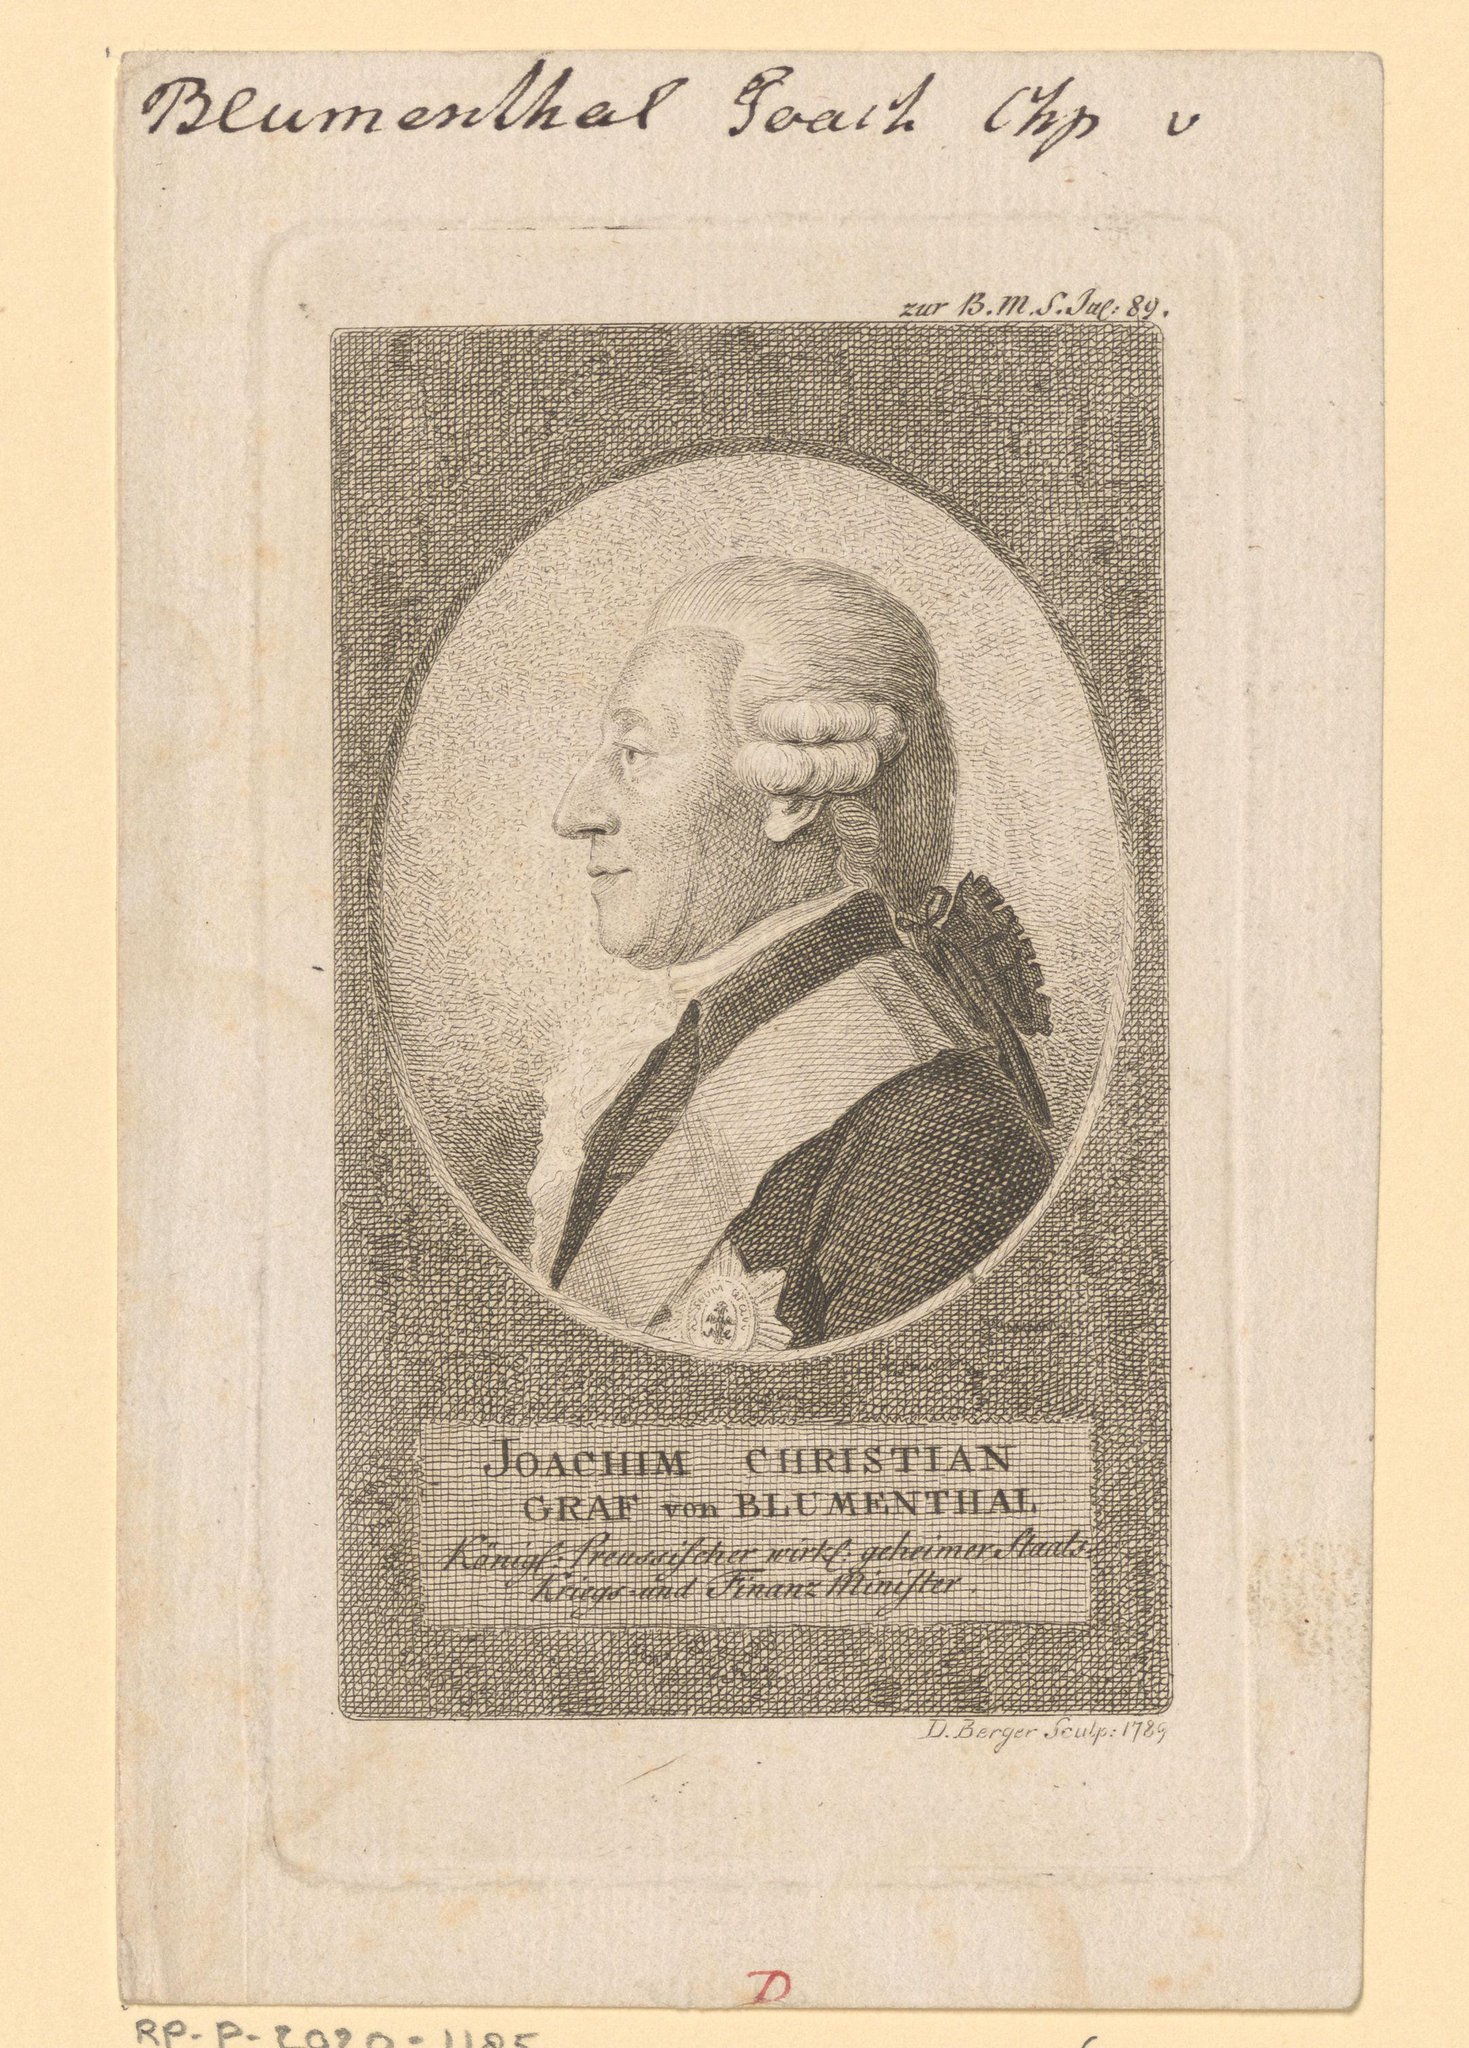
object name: print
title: Portret van Joachim Christian von Blumenthal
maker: daniel berger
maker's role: print maker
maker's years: 1744-1824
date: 1789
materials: paper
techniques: etching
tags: minister ~ government, historical persons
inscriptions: date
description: Rechtsboven genummerd: zur B.M.S. Jul: 89.